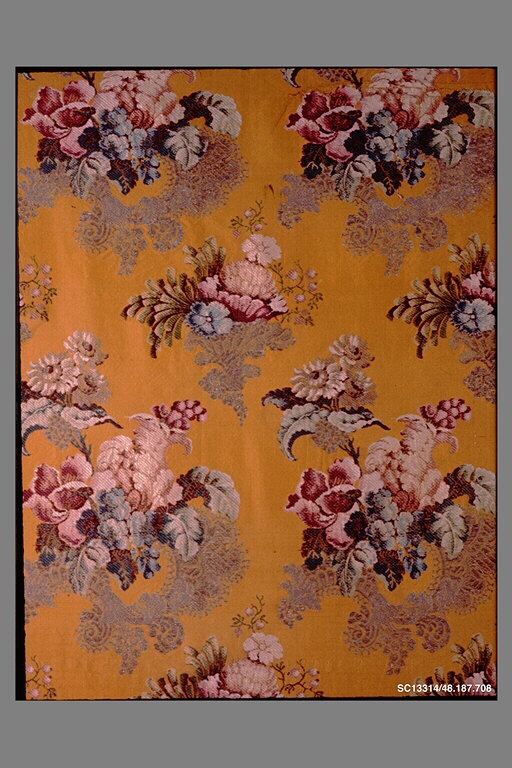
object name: piece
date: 1735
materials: metal thread, silk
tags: flowers,leaves